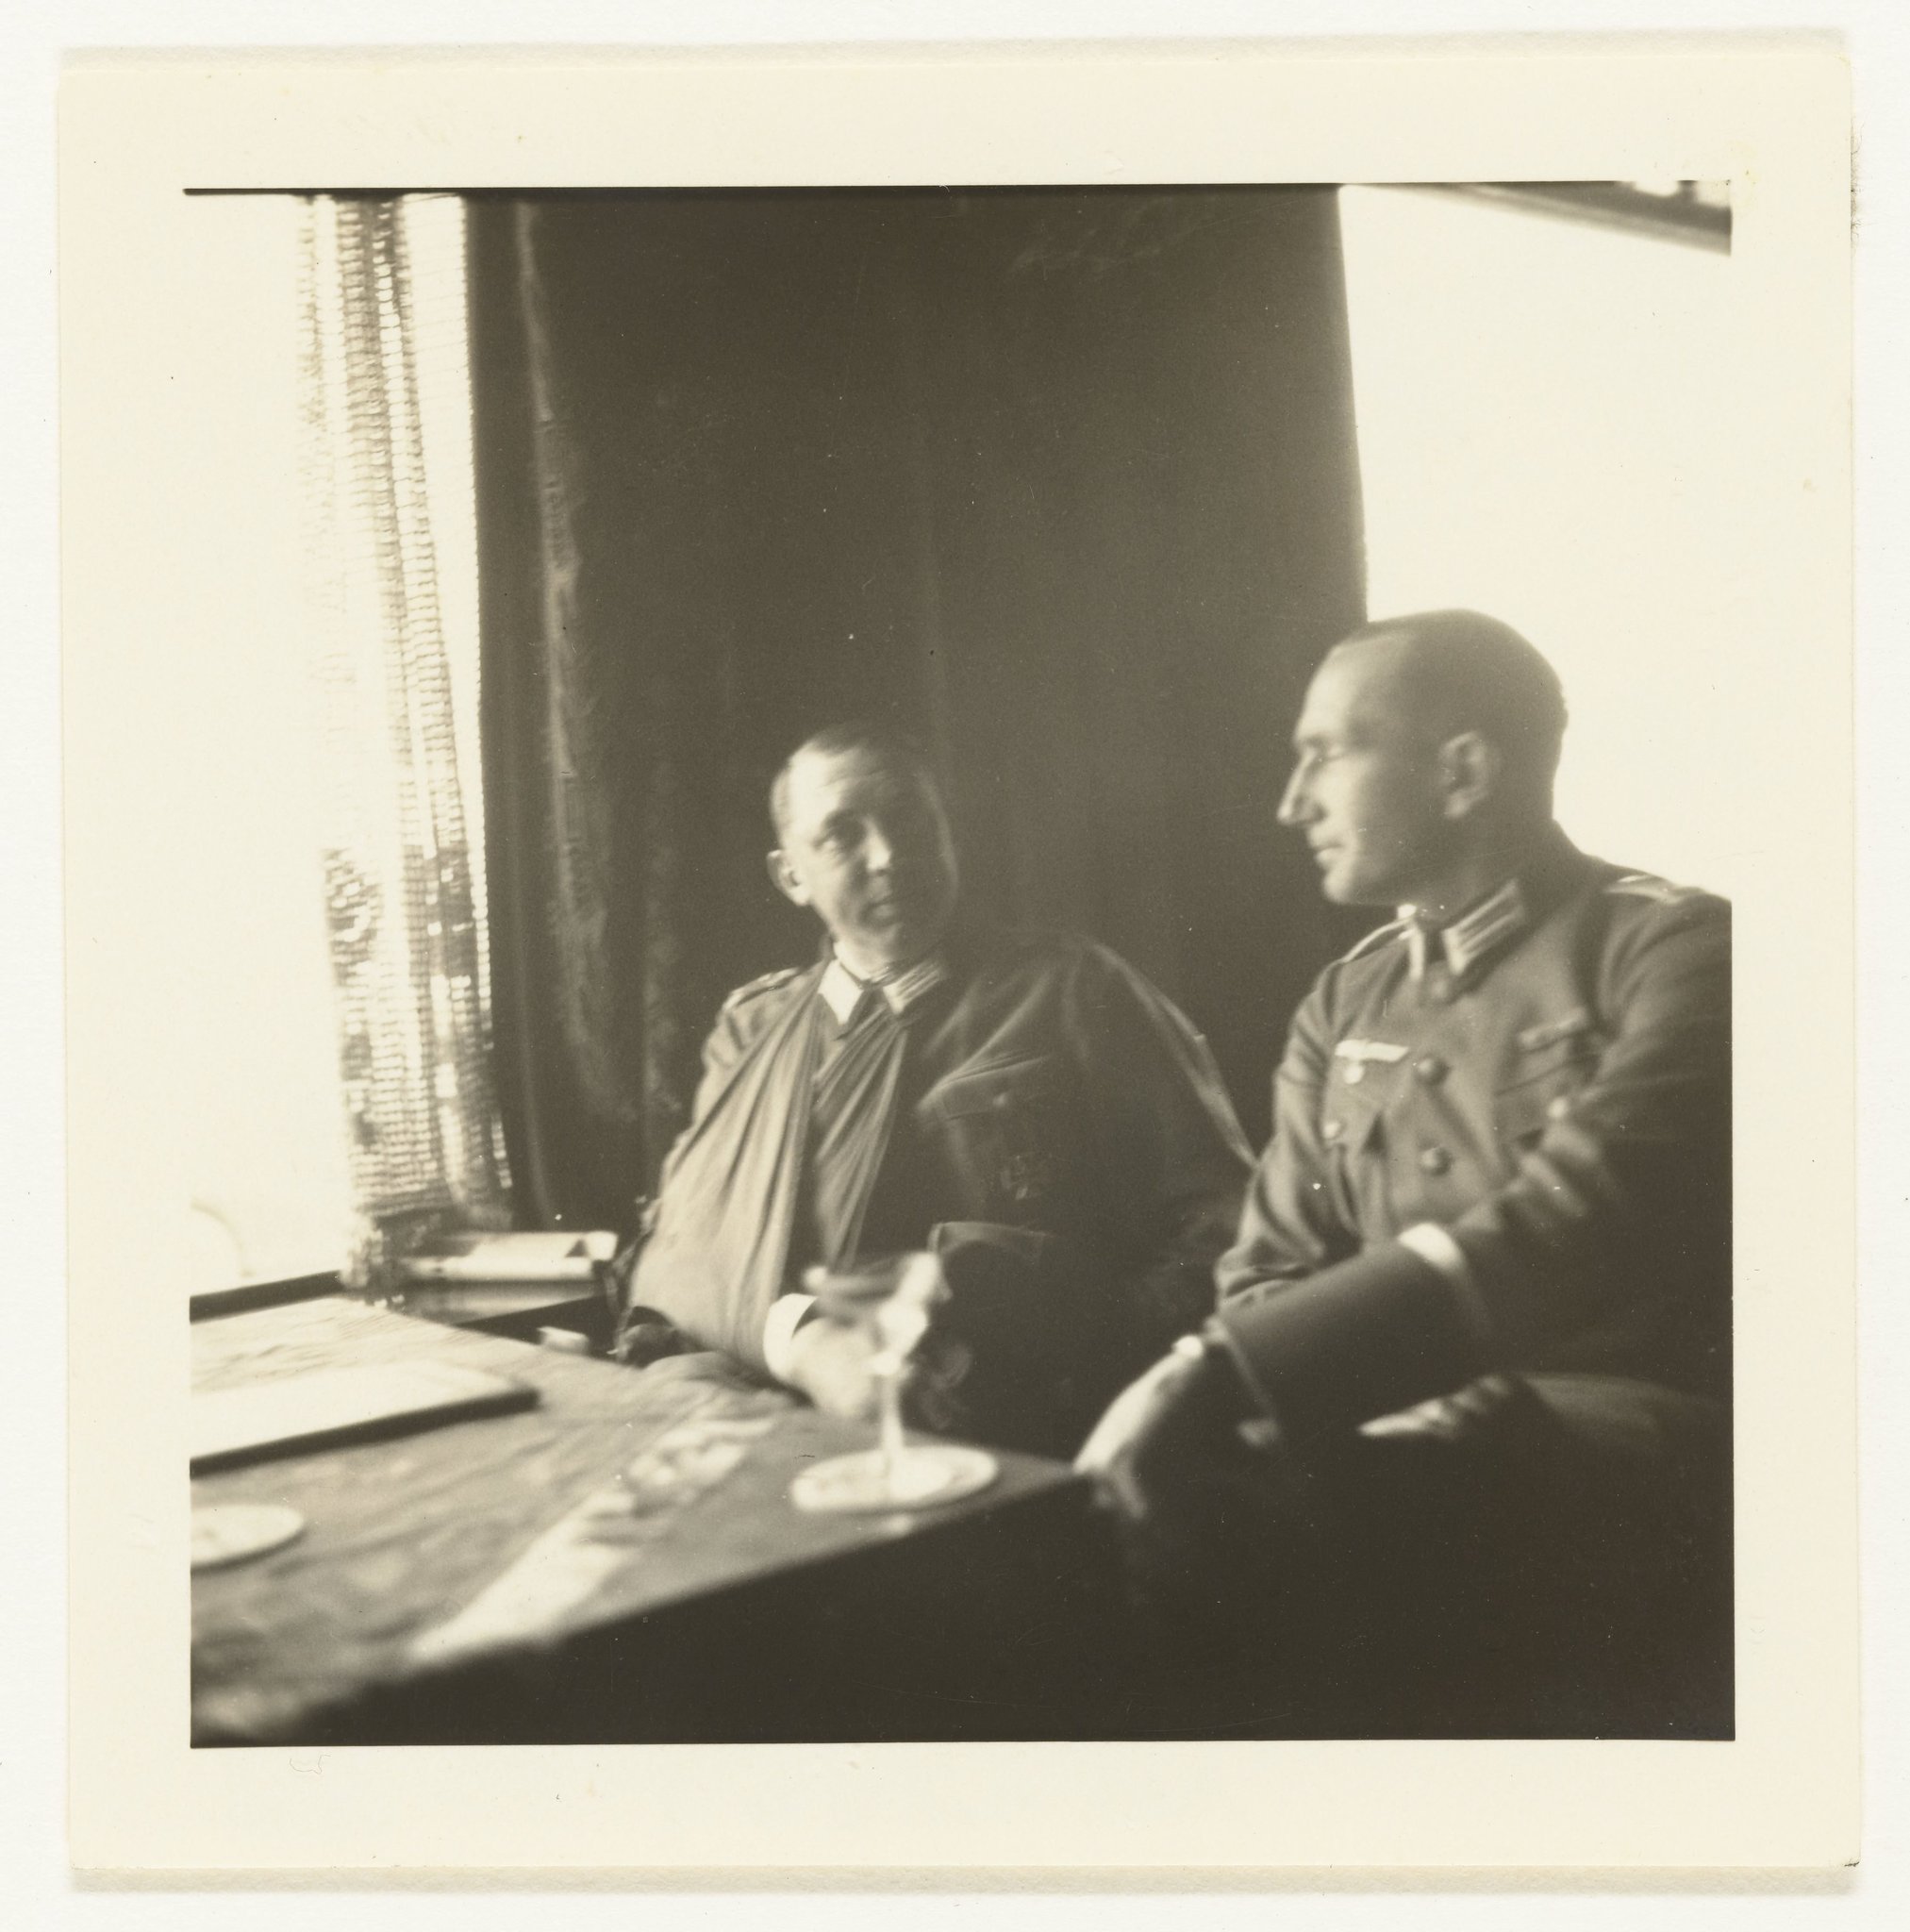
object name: photograph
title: Twee Duitse militairen.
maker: Anonymous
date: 1940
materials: photographic support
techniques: gelatin silver print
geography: katwijk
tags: occupation ~ war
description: Twee duitse militairen zitten aan tafel, de linker heeft zijn arm in een mitella. Achterop staat: Die .... und der Retter von Falkenbürg, Holland. 16. 5.40